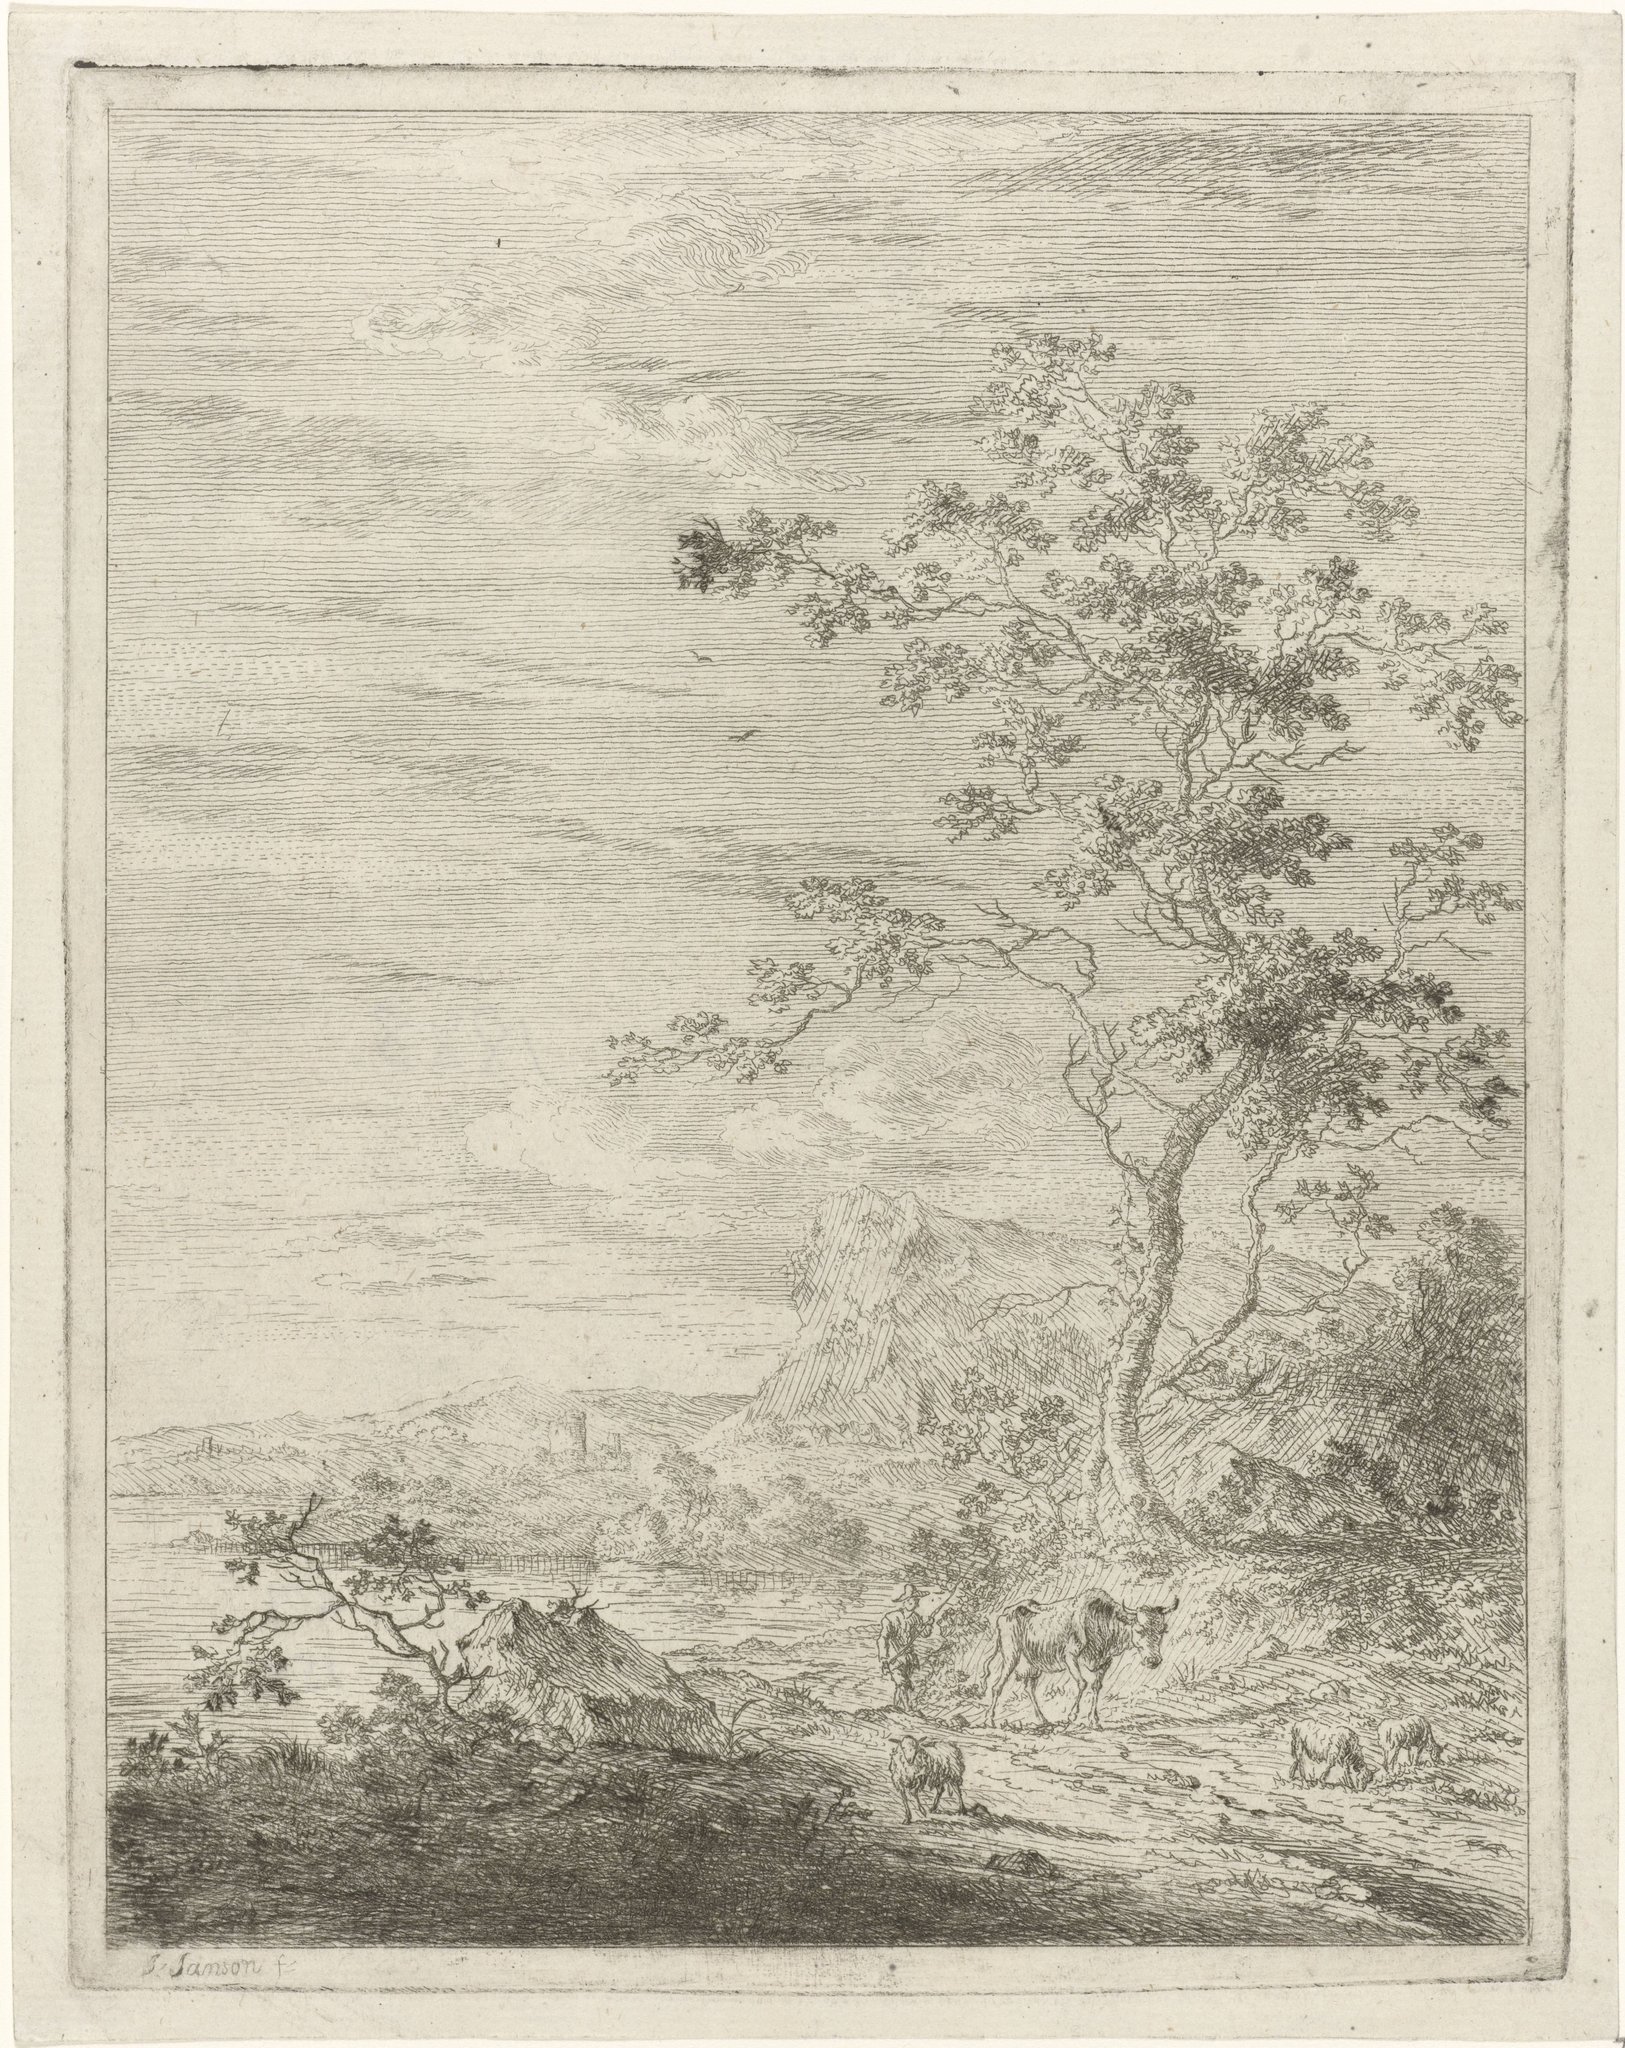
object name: print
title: Bergachtig landschap met herder en vee op pad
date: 1761-1834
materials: paper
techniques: etching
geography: leiden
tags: cow, sheep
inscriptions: collector's mark: Lugt 2228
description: Bergachtig landschap met herder, koe en schapen op een pad. Links op de achtergrond een meer. Kopie in spiegelbeeld naar gelijknamige prent van Johannes Janson.